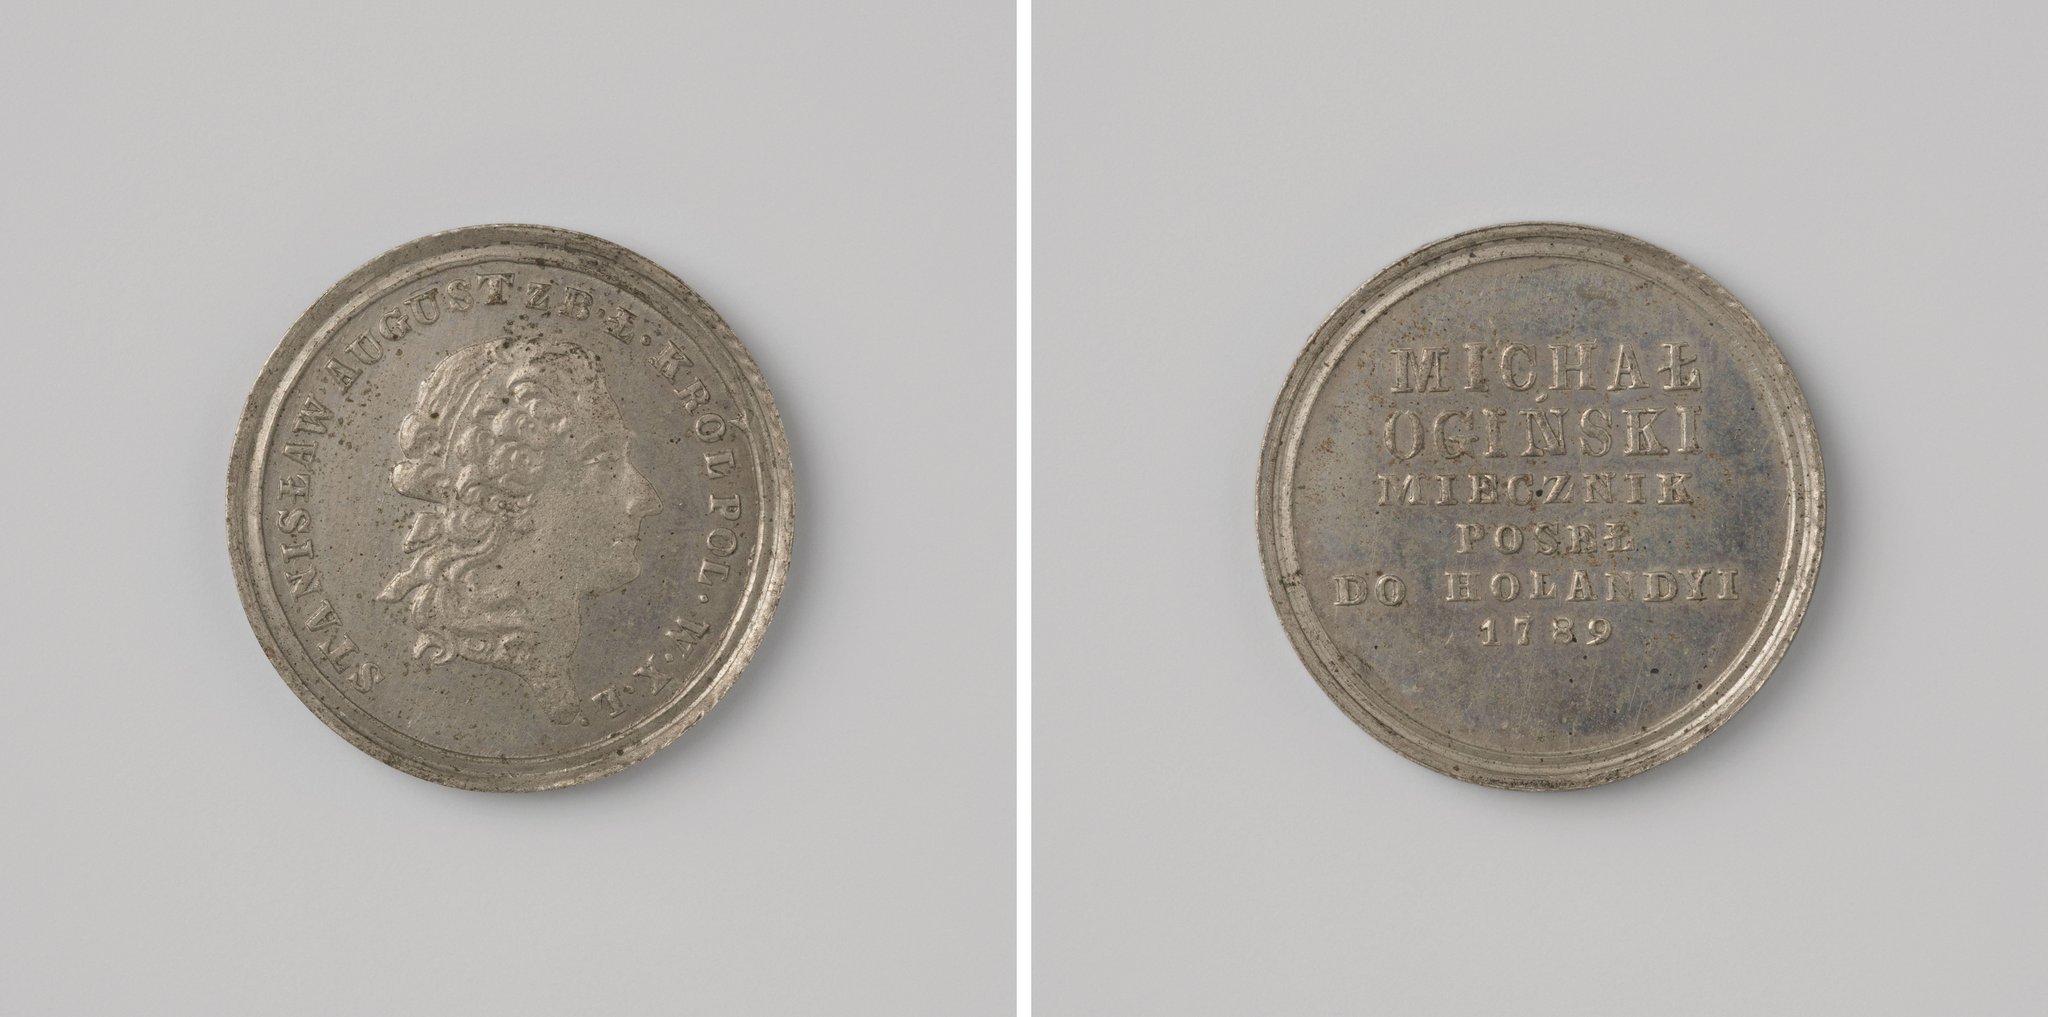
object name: history medal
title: Michal Oginski, gezant in de Nederlanden van Stanislaus II Augustus Poniatowski, koning van Polen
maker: Anonymous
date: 1789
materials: silver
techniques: striking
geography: poland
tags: wolczyn, sint-petersburg, koning, stanislaus ii augustus poniatovski (koning van polen), michal oginski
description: Zilveren penning. Voorzijde: borststuk man binnen omschrift. Keerzijde: opschrift